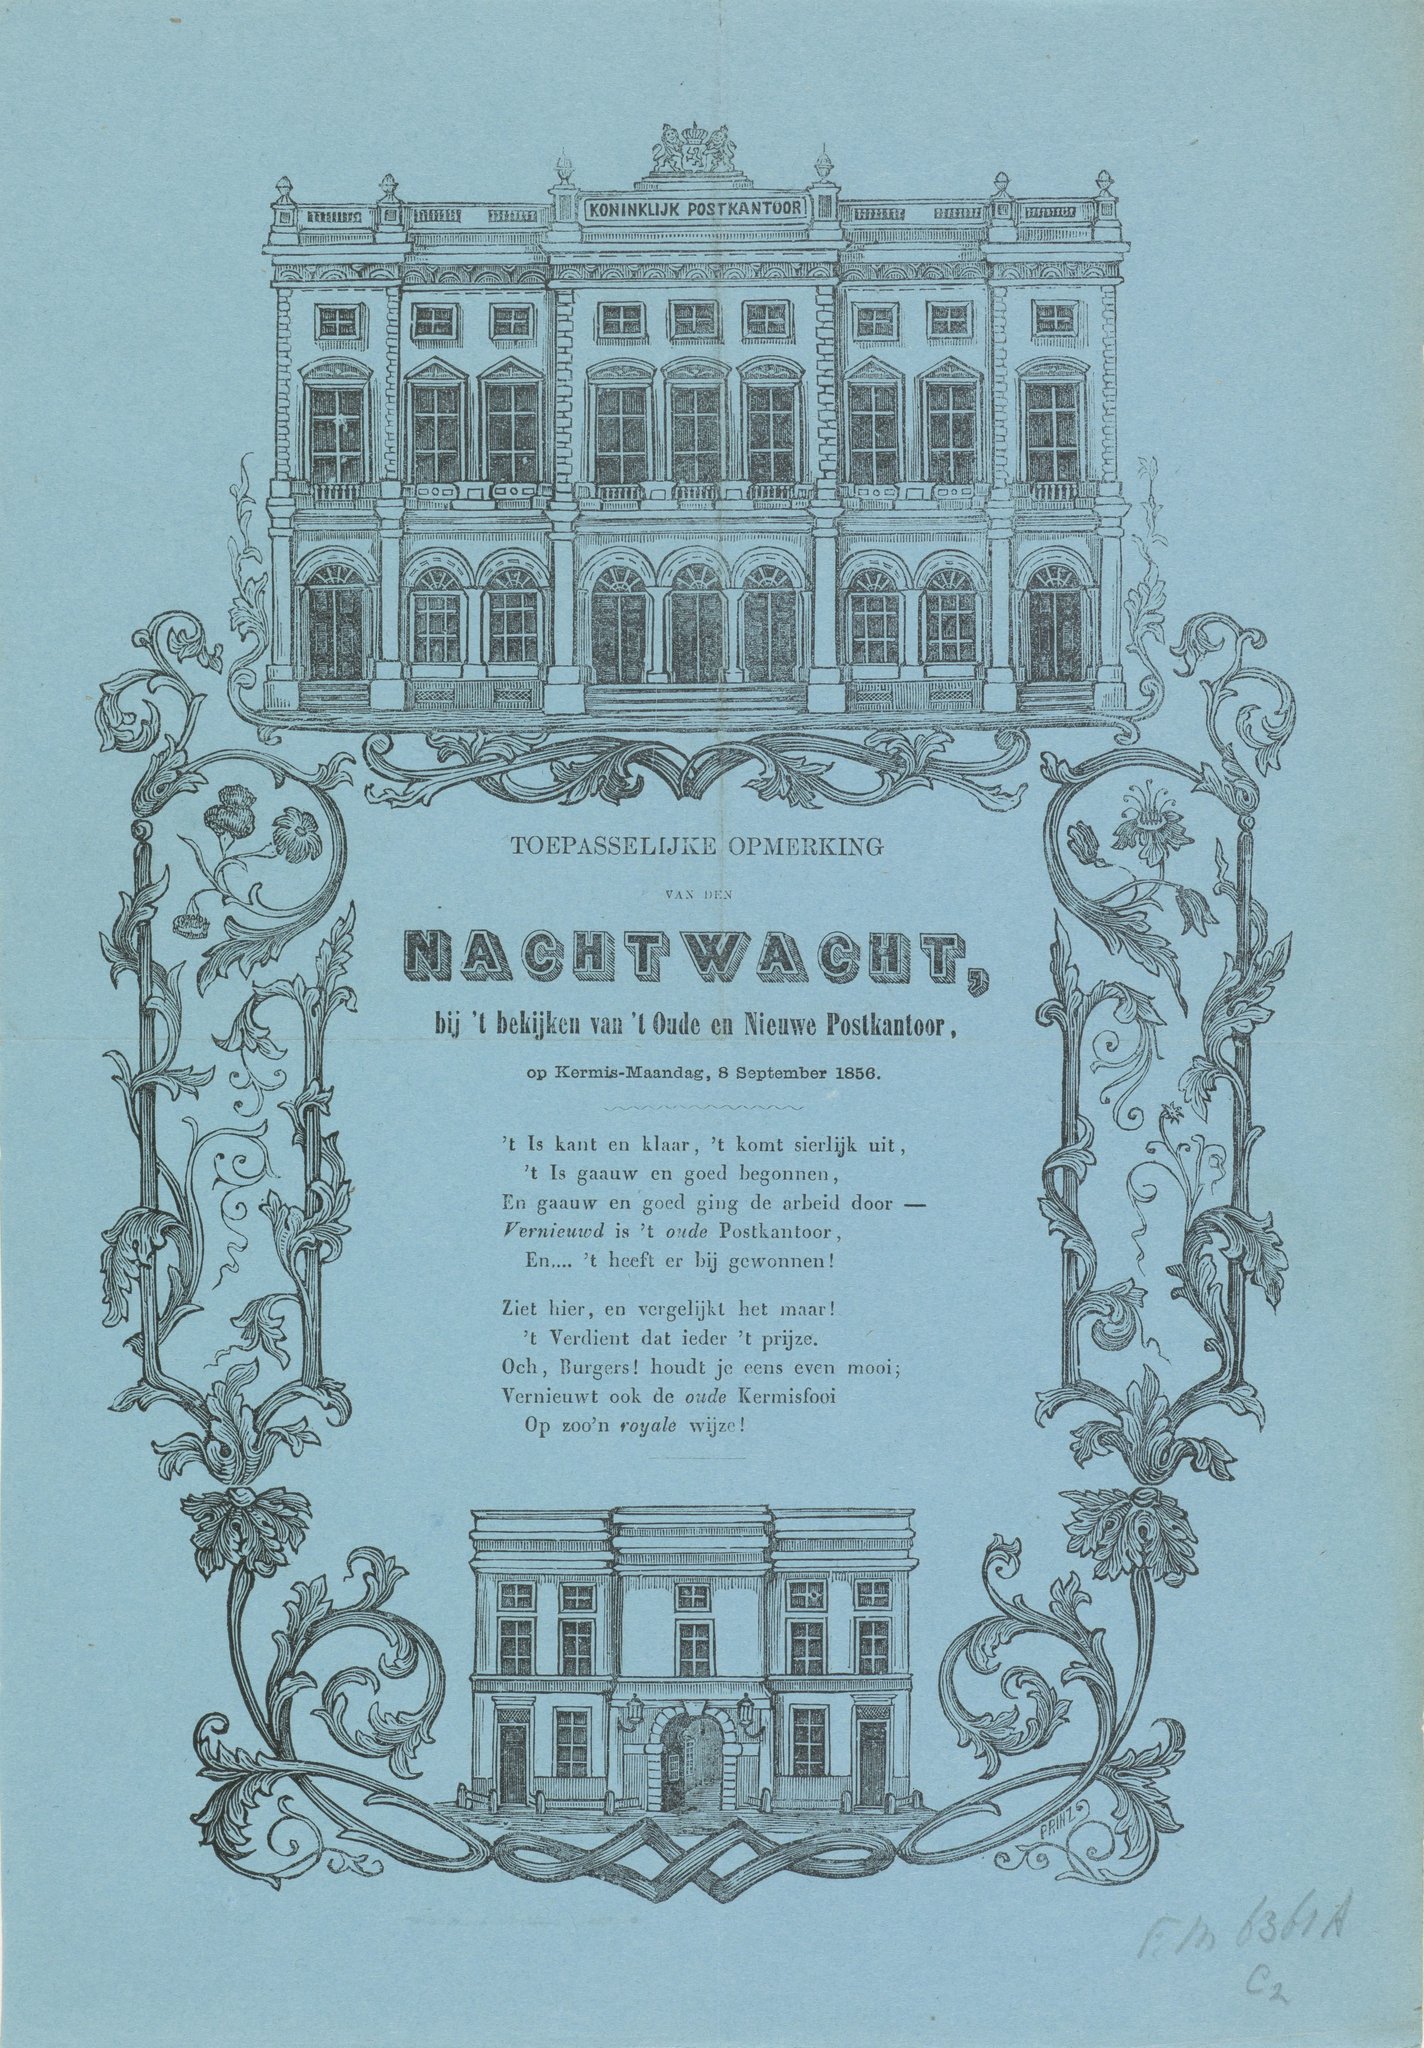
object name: print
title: Toepasselijke opmerking van den Nachtwacht, bij 't bekijken van 't Oude en Nieuwe Postkantoor, op Kermis-Maandag, 8 September 1856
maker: friedrich robert prinz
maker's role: print maker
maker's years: 1820-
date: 1856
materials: paper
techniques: letterpress printing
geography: netherlands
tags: night patrol, post-office, amsterdam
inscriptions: collector's mark: Lugt 2228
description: Kermisprent van de Amsterdamse nachtwacht (ratelwacht), 8 september 1856. Twee voorstellingen van het oude postkantoor of Generaal Post Comptoir, afgebroken in 1854 om plaats te maken voor het nieuwe Koninklijk Postkantoor. Centraal een gedicht in twee verzen.